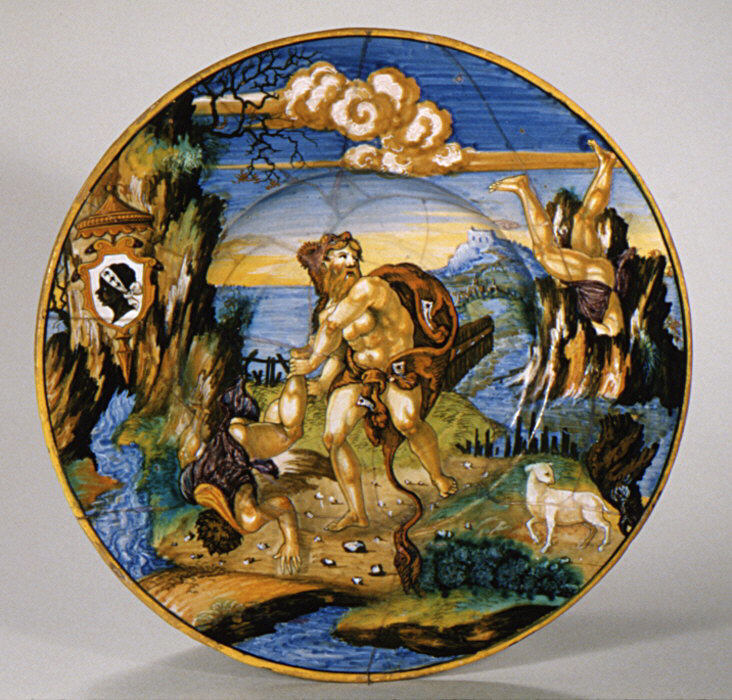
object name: plate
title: Plate with Hercules and Lichas and arms of the Pucci family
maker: fra xanto avelli da rovigo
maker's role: artist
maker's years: 1486-1582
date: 1532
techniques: maiolica, glazing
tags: animals,hercules